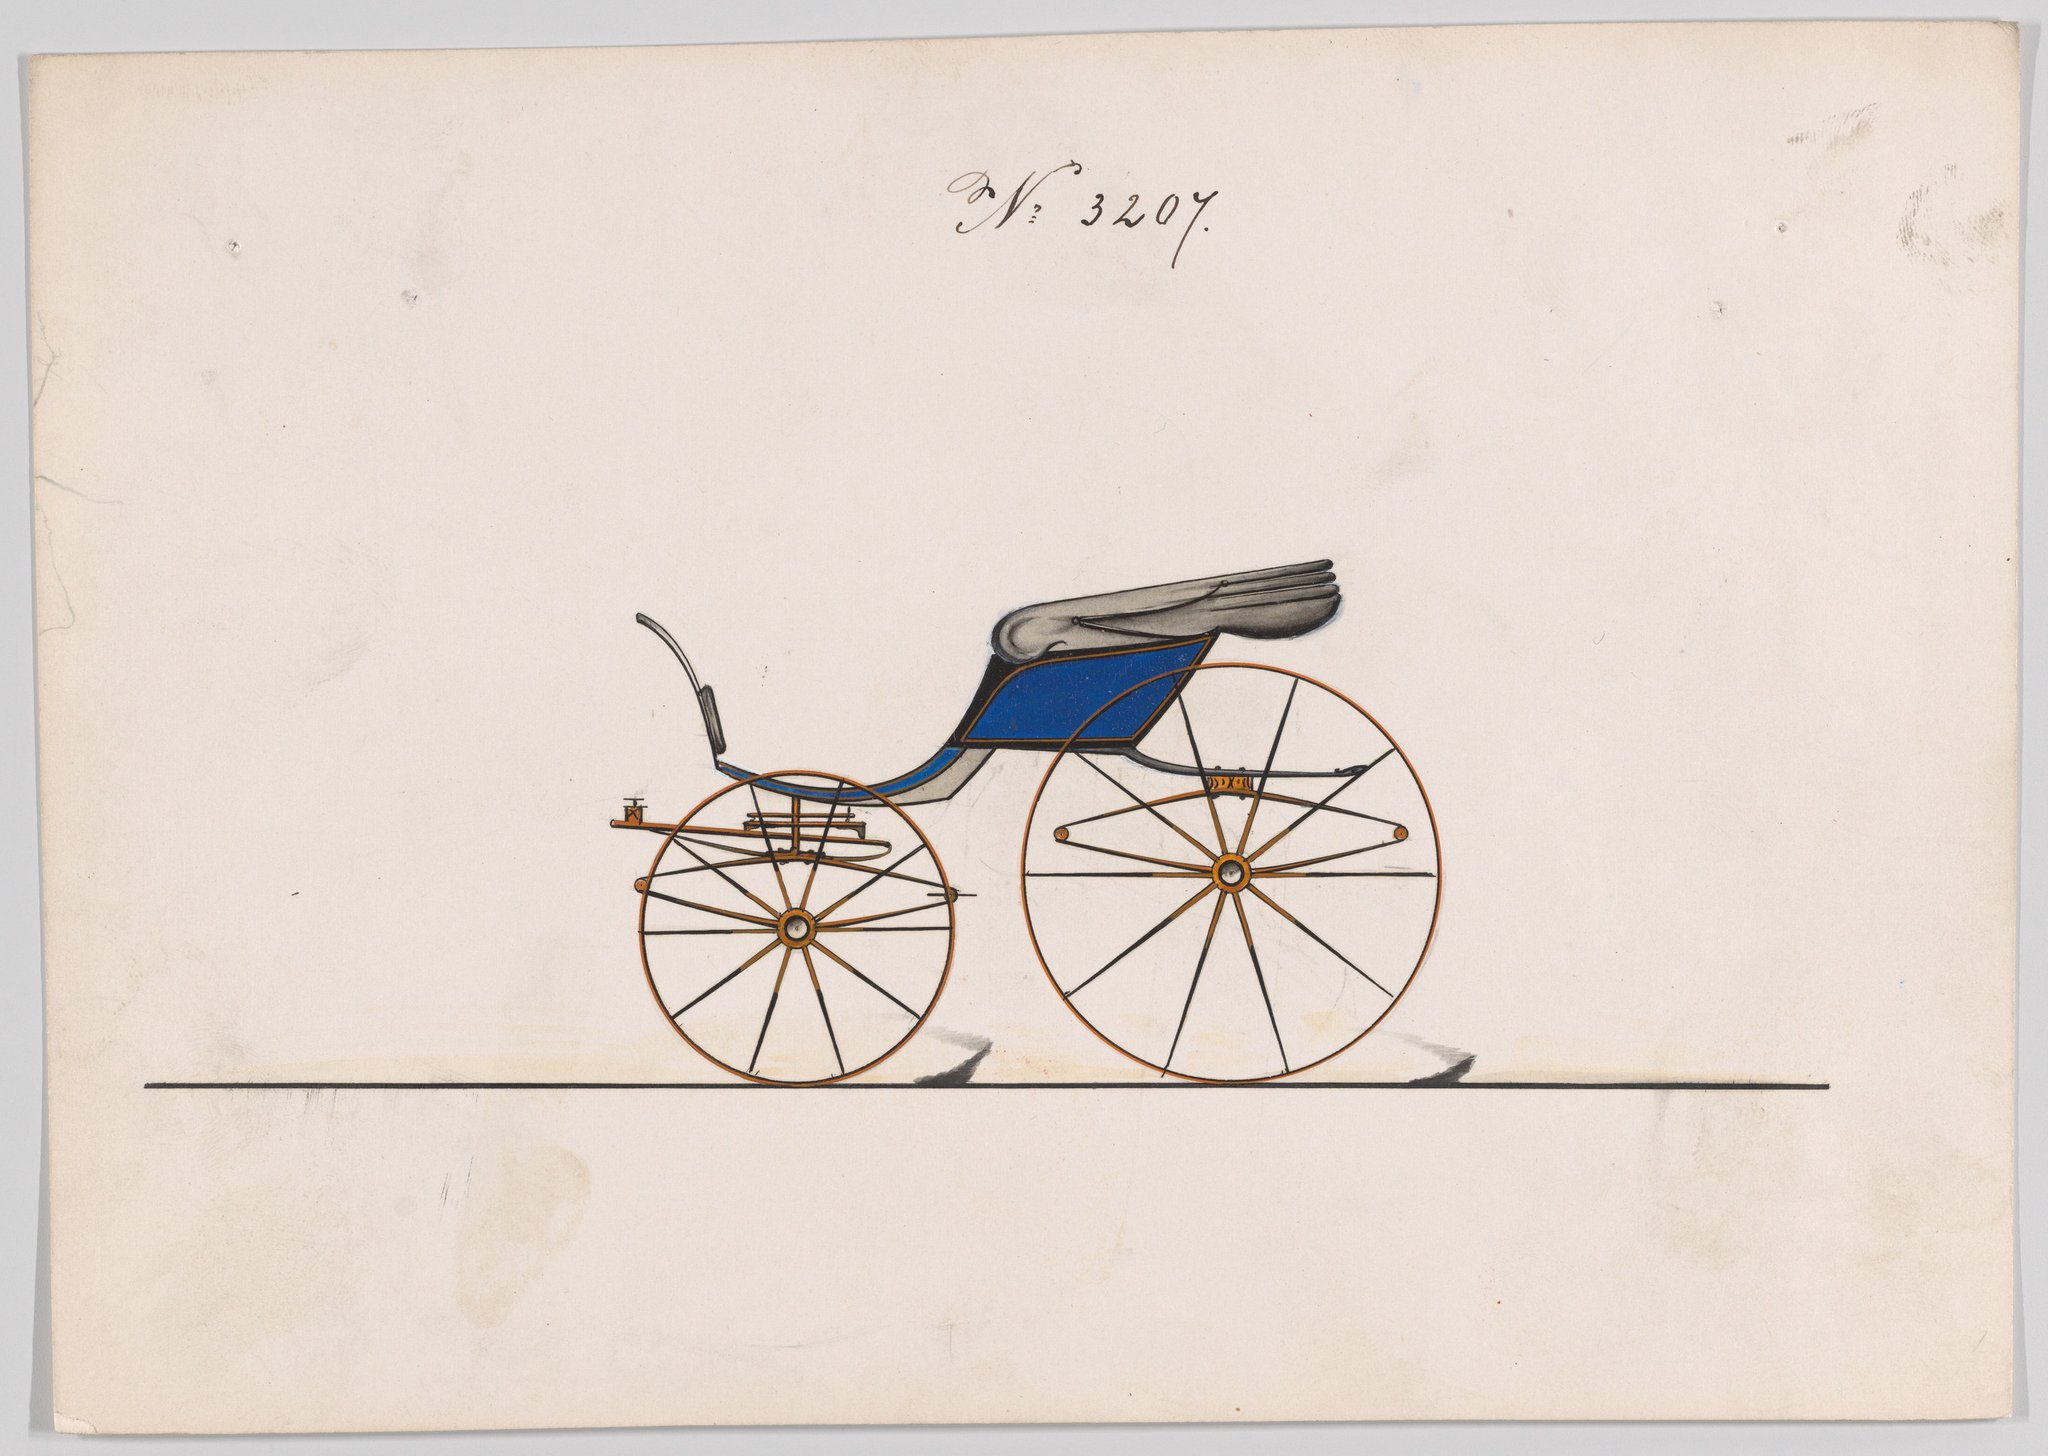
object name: drawing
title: Design for Pony Phaeton, no. 3207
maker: brewster & co.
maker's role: manufacturer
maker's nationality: american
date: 1876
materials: gouache, gum arabic, ink, watercolor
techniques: pen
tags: carriages